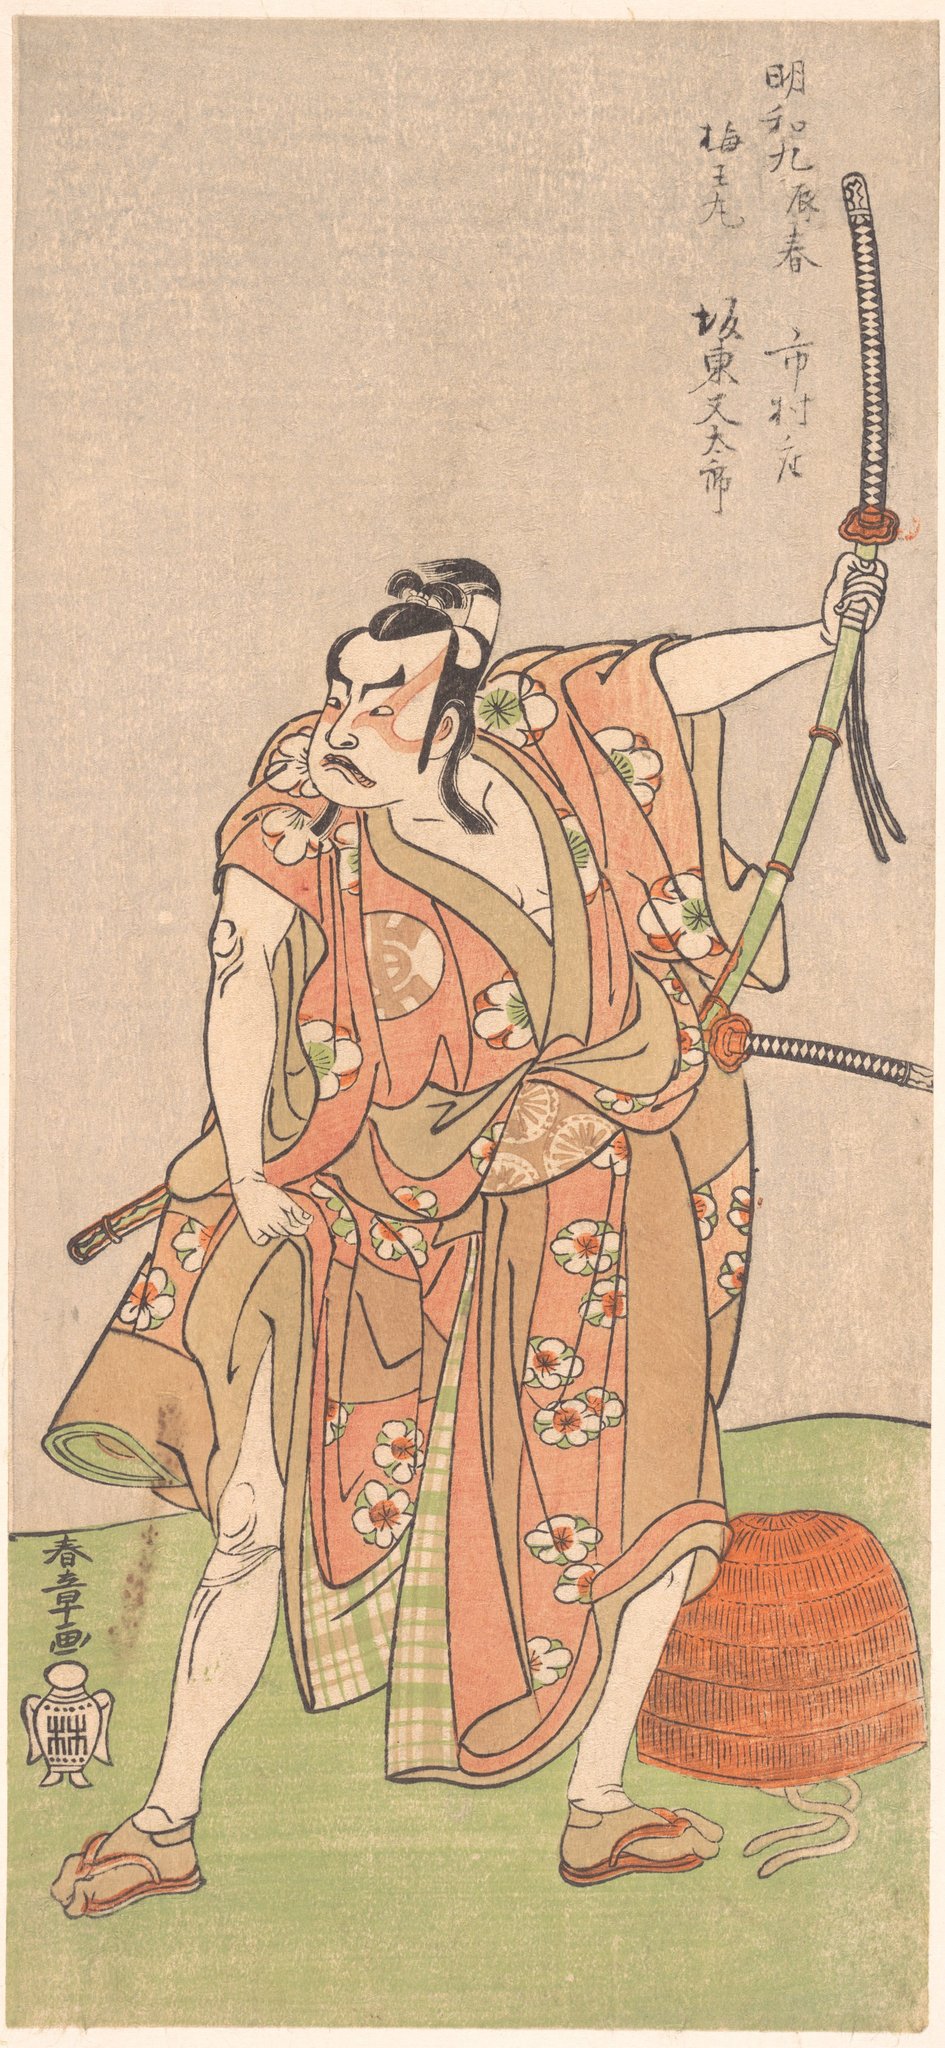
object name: woodblock print nishiki e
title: Bando Matataro as Umewomaru in the Drama "Sugewara denju tenarai Kagami"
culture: japanese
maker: katsukawa shunshō 勝川春章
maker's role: artist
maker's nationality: japanese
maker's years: 1726-1792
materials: ink, paper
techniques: nishiki e, woodblock print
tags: theatre,men,actors